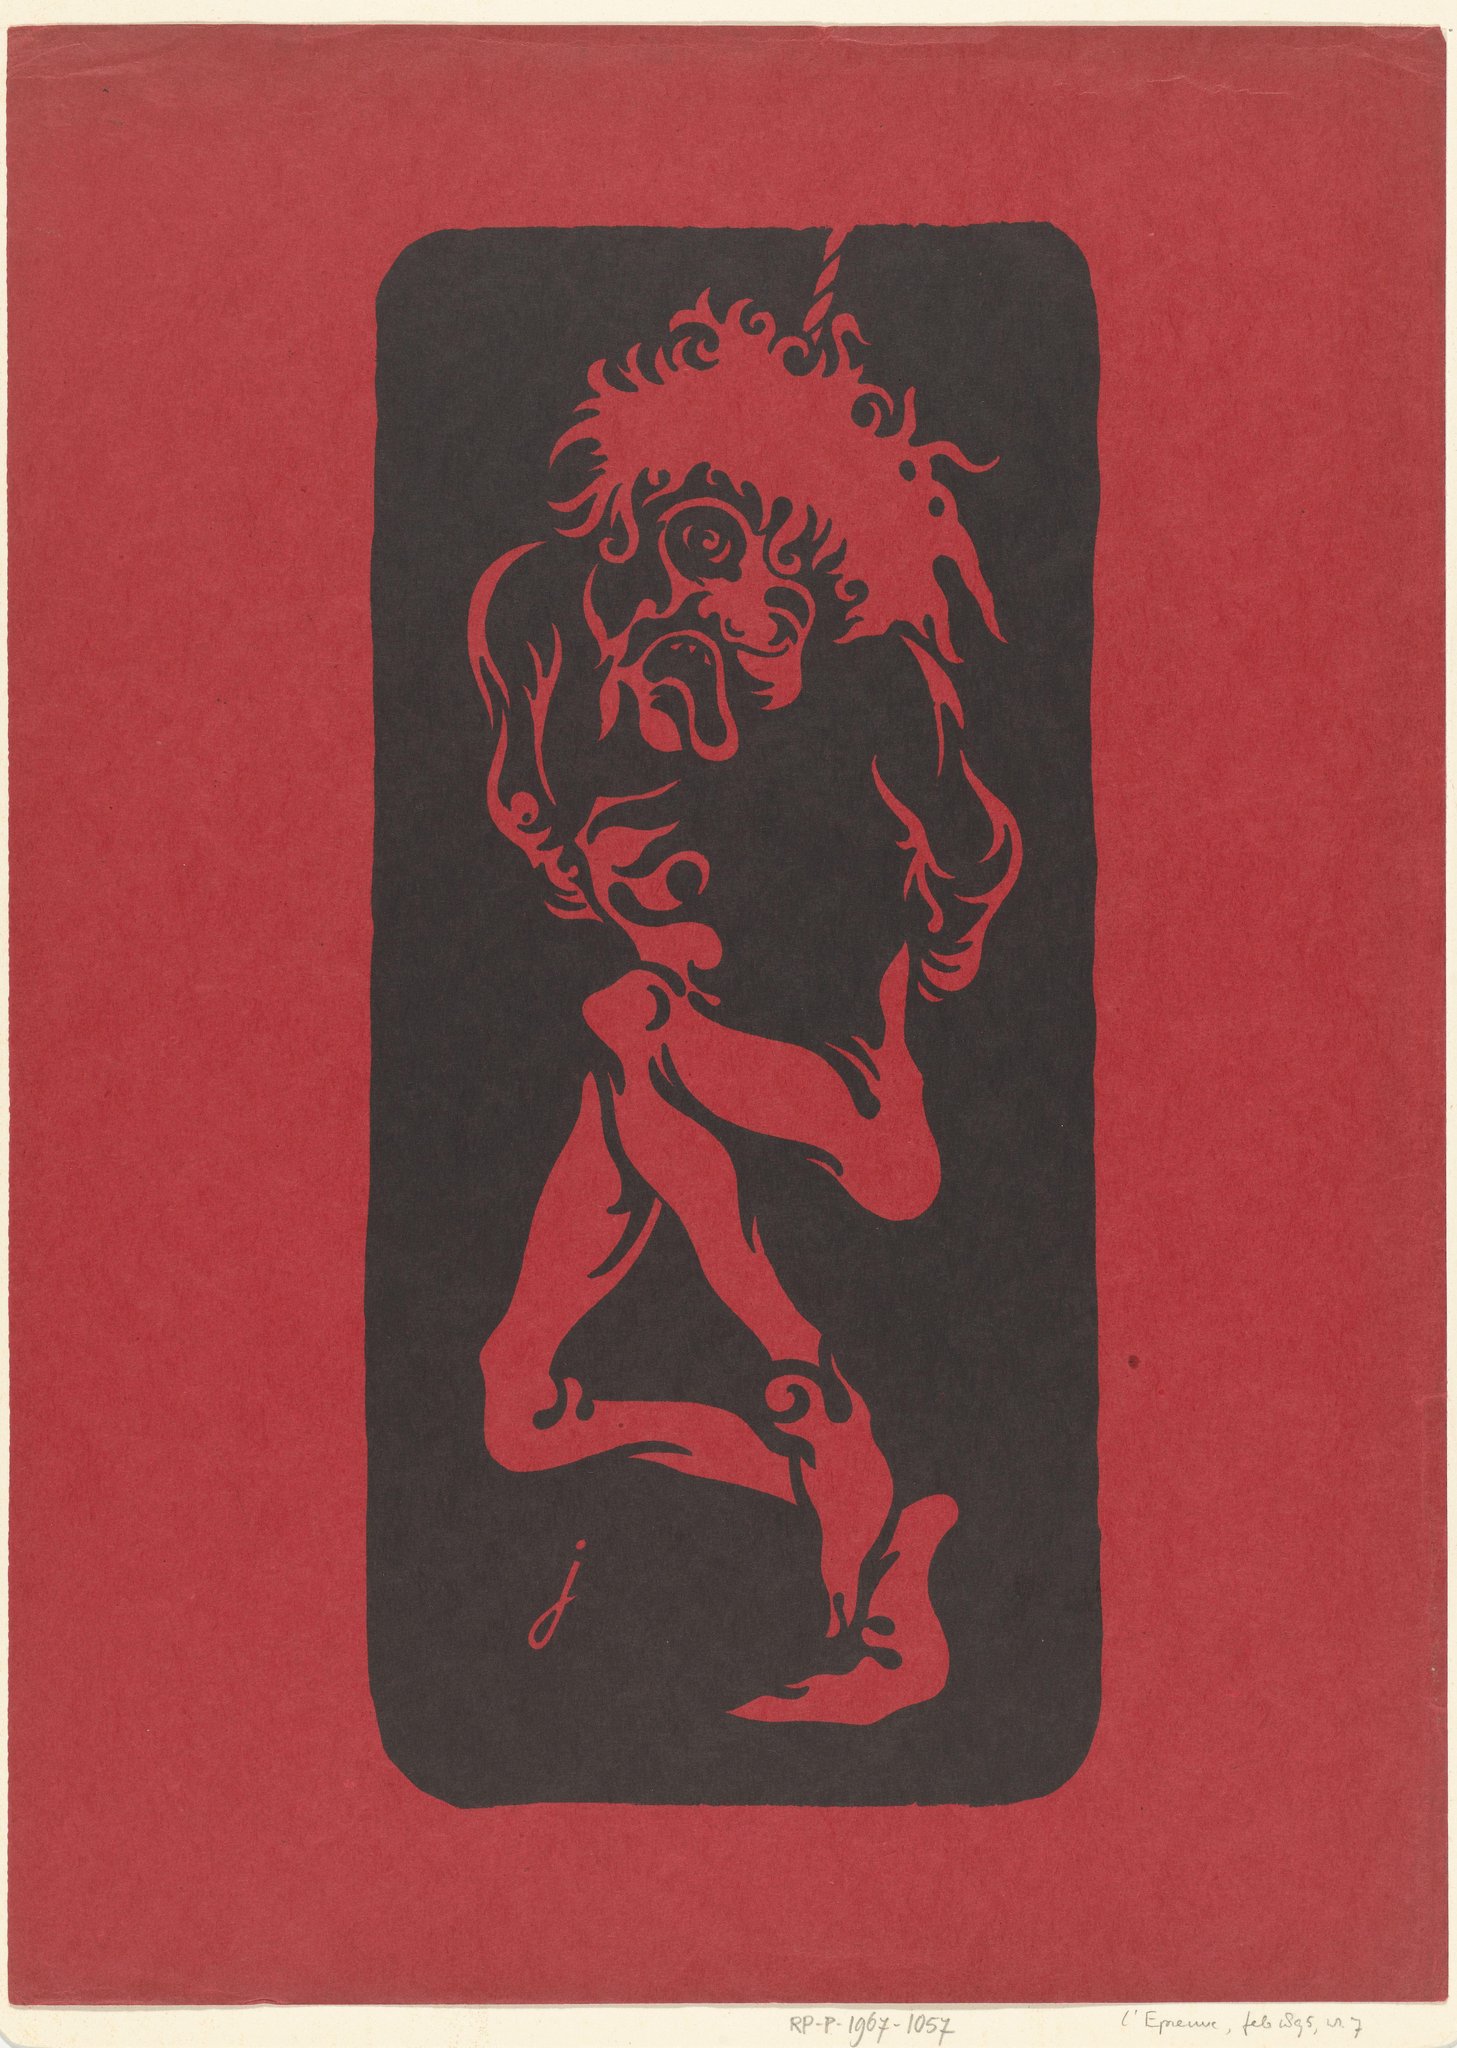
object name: print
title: L'Epreuve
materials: paper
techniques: lithograph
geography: paris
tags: violent death by hanging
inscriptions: collector's mark: Lugt 2228, collector's mark: Lugt 2760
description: Verschenen in album met tien originele prenten bij tijdschrift: L'Epreuve, februari 1895, prent nr. 7